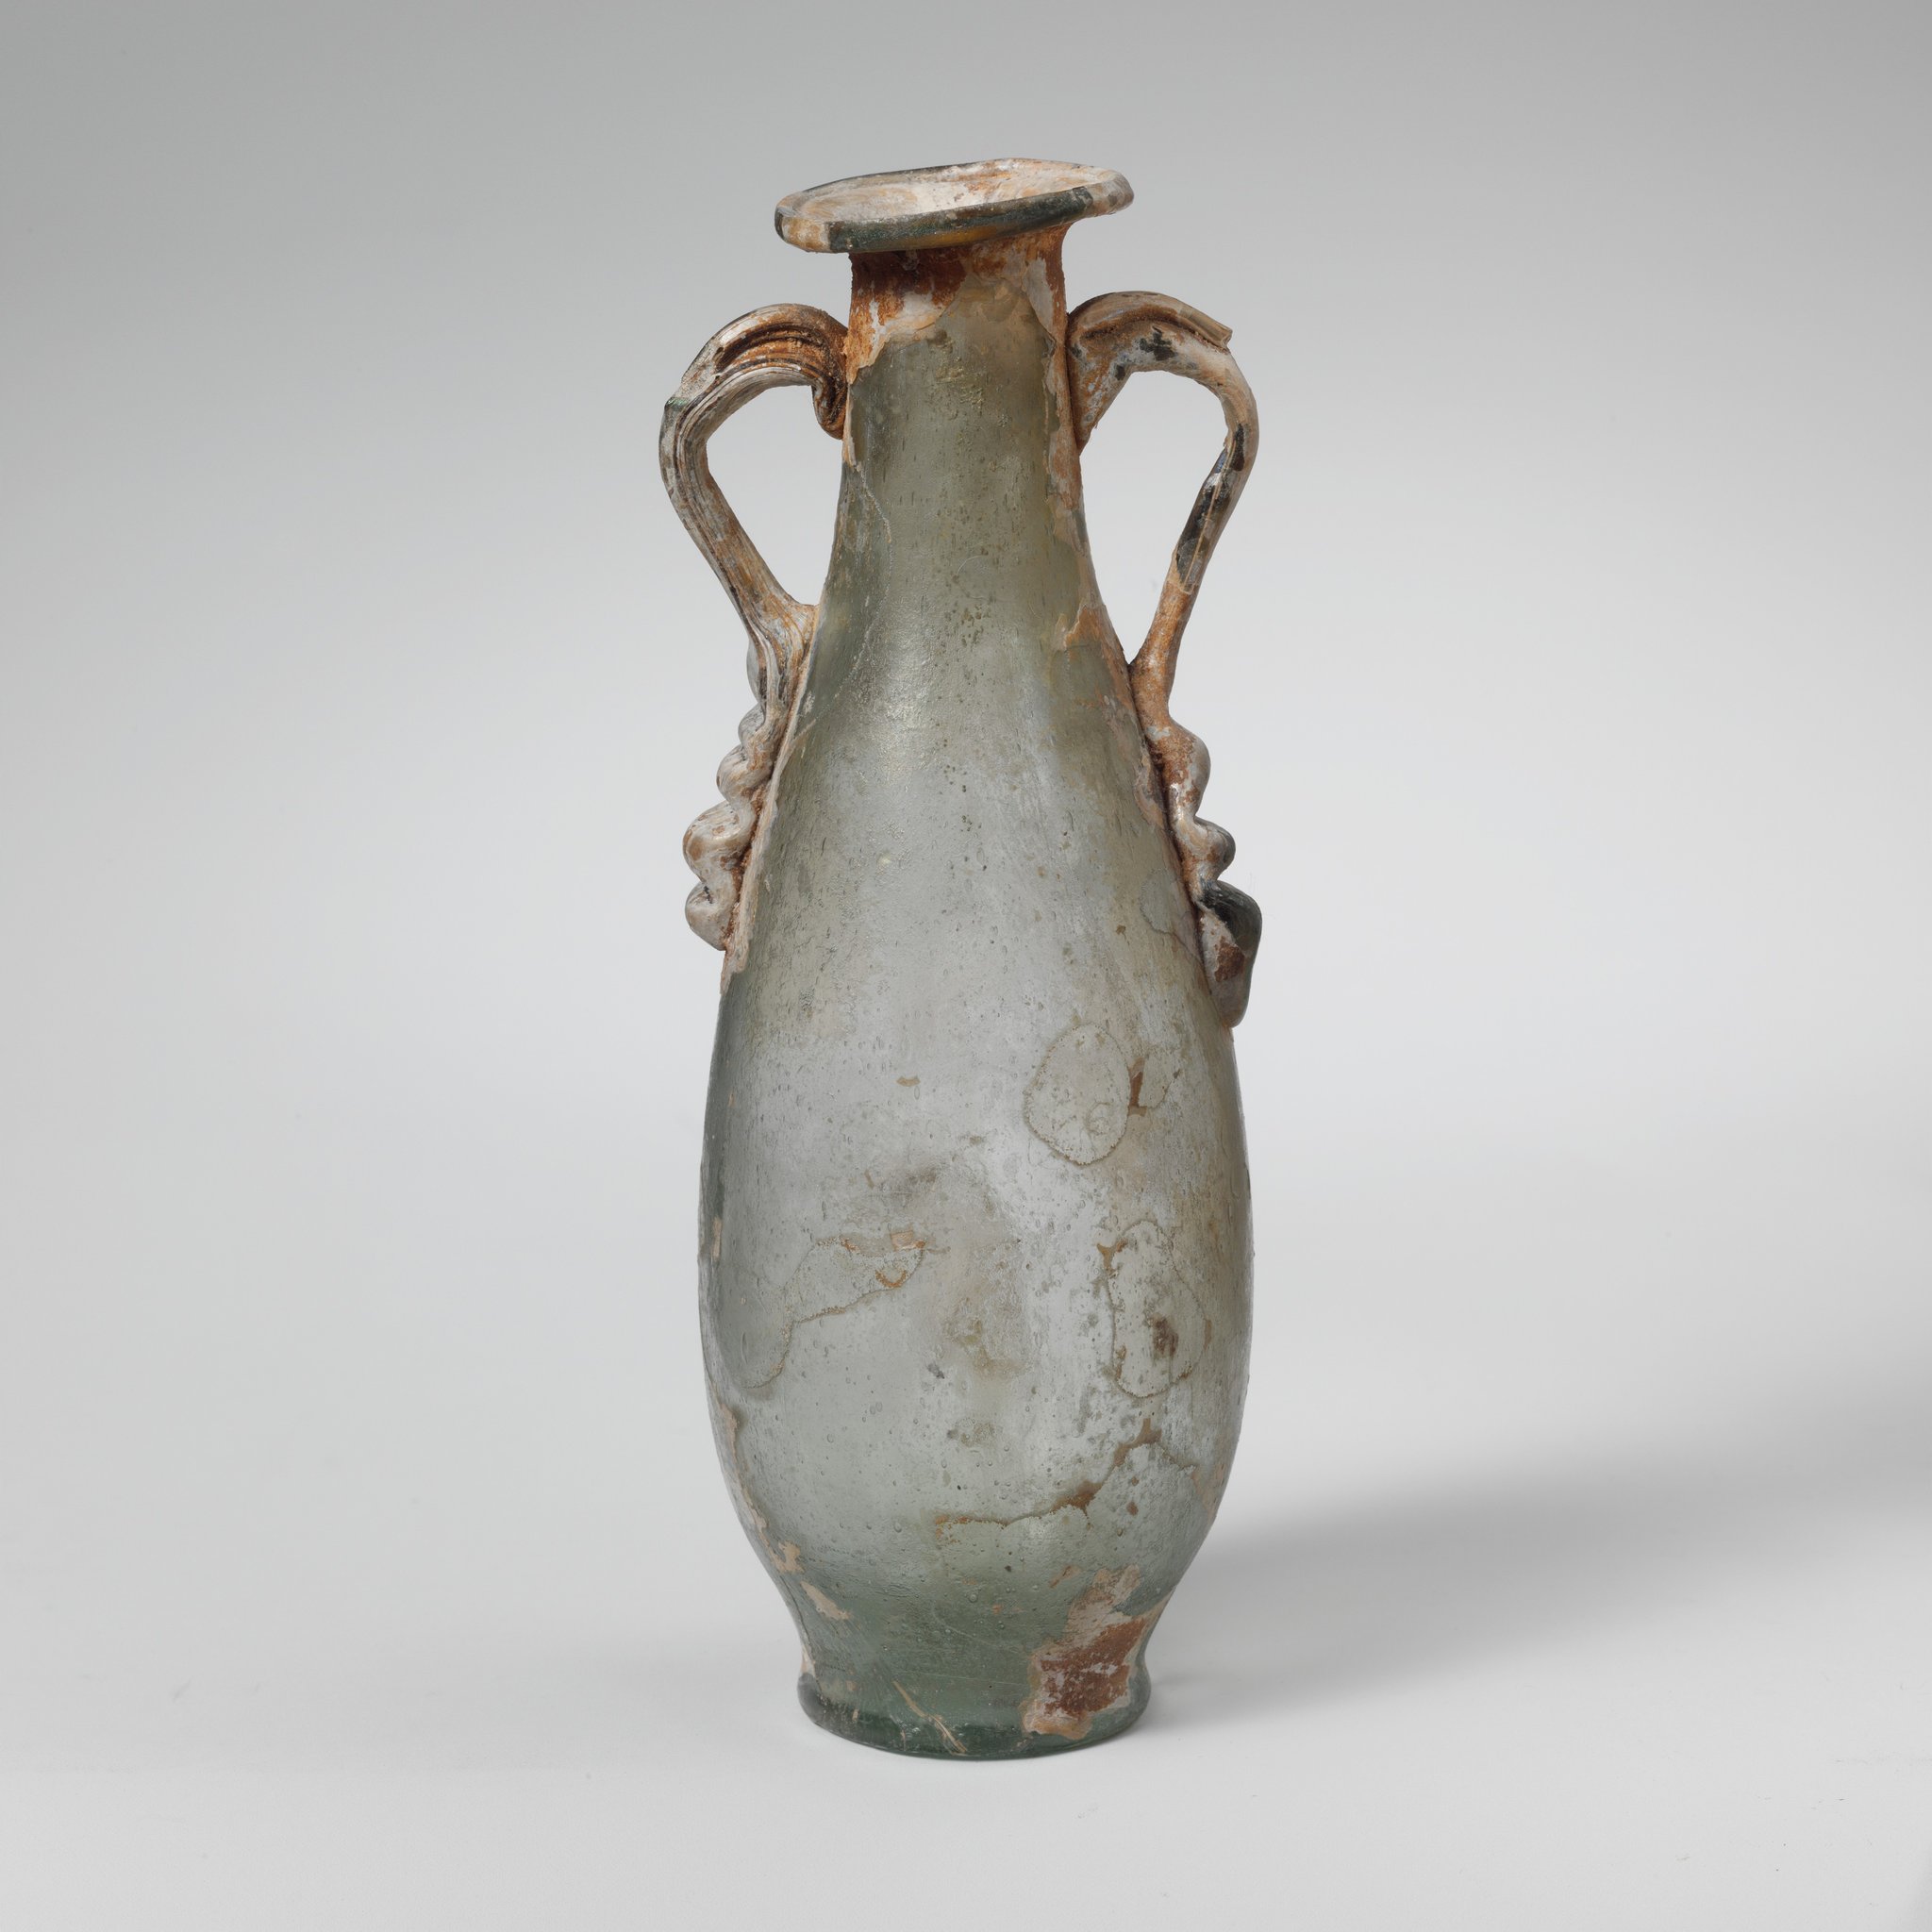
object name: bottle, two handled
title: Glass two-handled bottle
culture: roman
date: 101-300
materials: glass